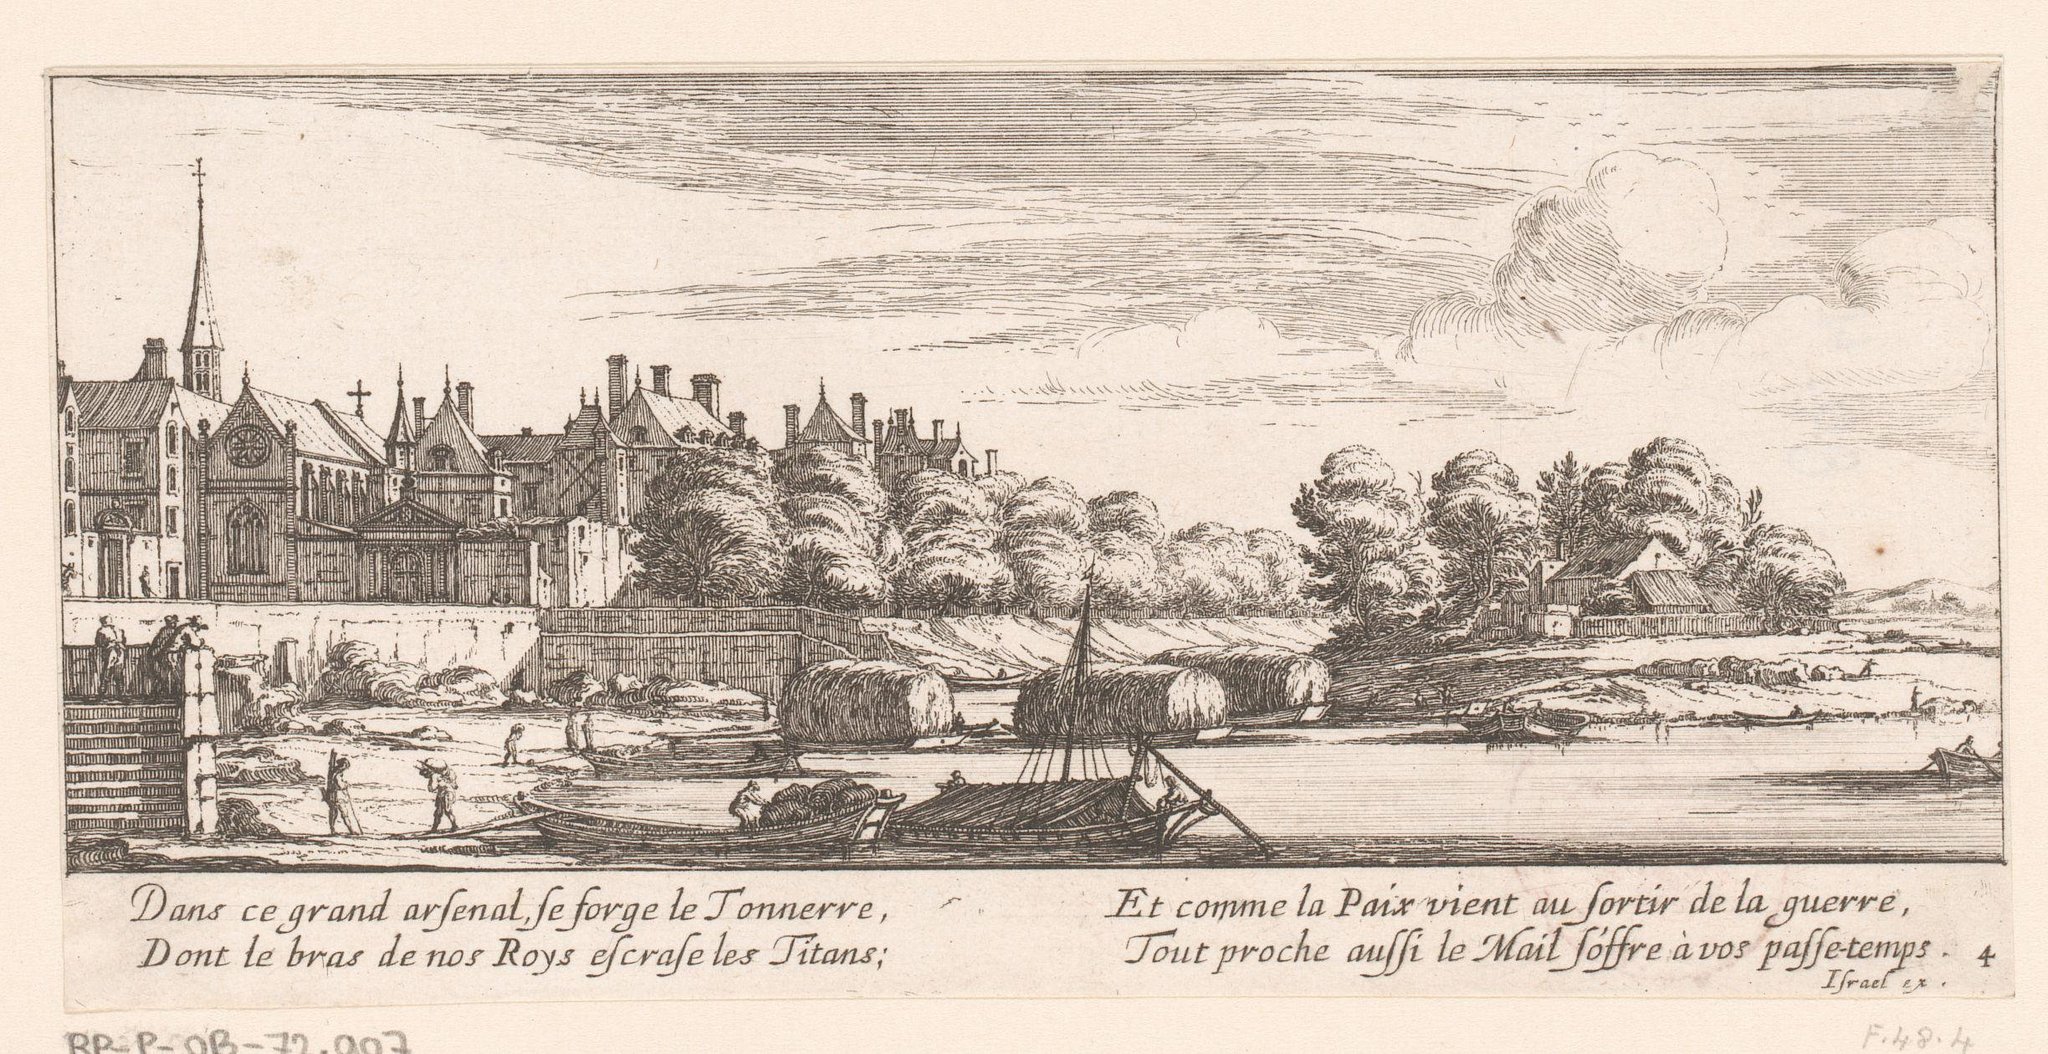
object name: print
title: Gezicht op munitiedepot met daarvoor rivier met boten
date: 1655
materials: paper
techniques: engraving, etching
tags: city-view, and landscape with man-made constructions, ammunition store, arsenal, paris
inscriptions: collector's mark: Lugt 240